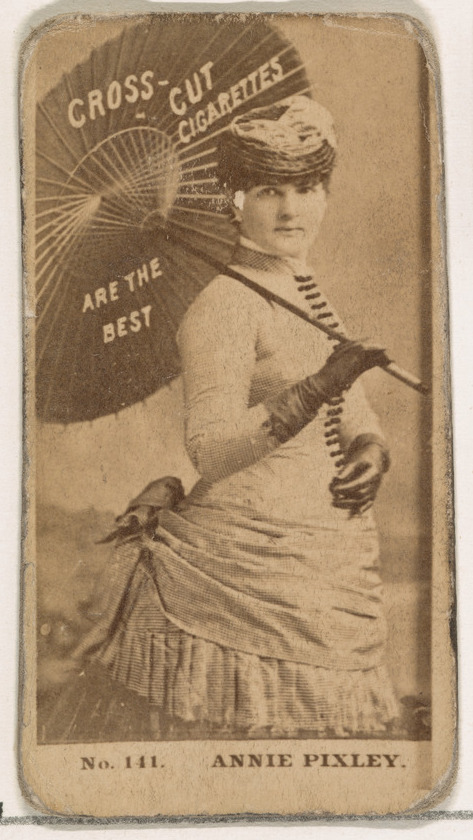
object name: print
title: Card Number 141, Annie Pixley, from the Actors and Actresses series (N145-2) issued by Duke Sons & Co. to promote Cross Cut Cigarettes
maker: w. duke, sons & co.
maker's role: publisher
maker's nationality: american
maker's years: 1870-1920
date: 1880-1889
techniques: albumen silver print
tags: portraits,women,actresses